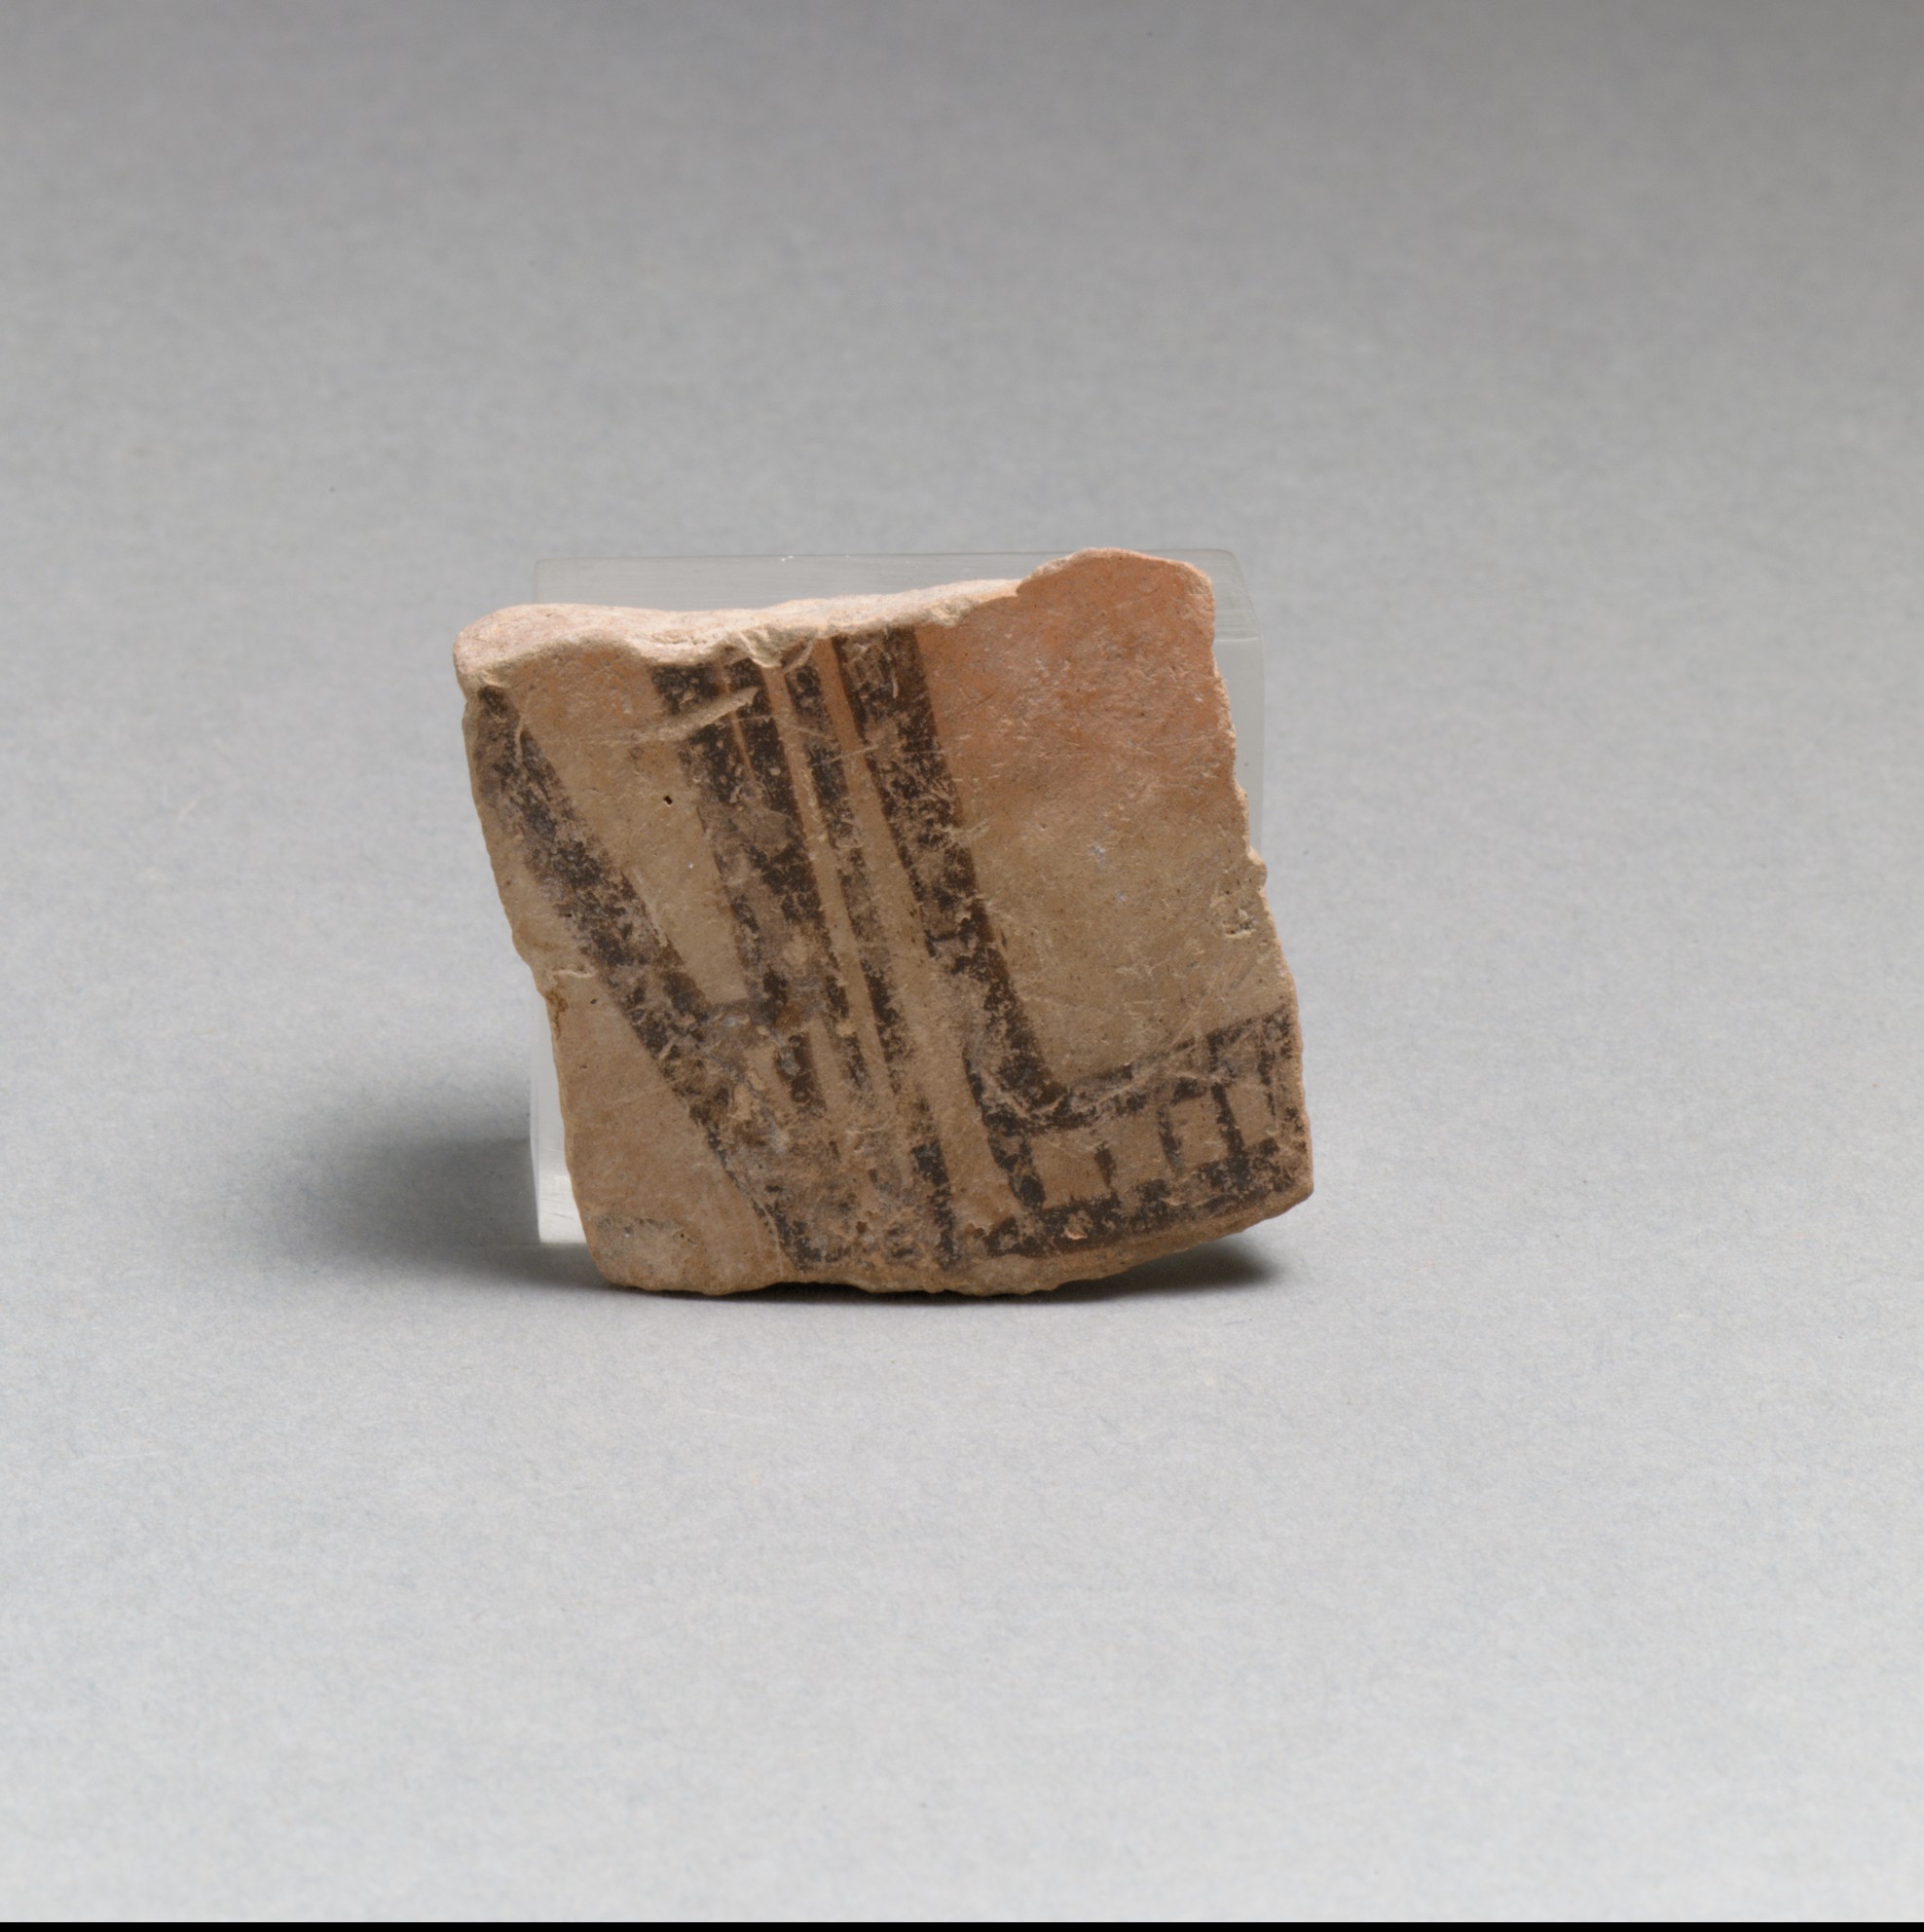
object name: vase fragment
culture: neolithic, thessaly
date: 4000-3000 BCE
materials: terracotta